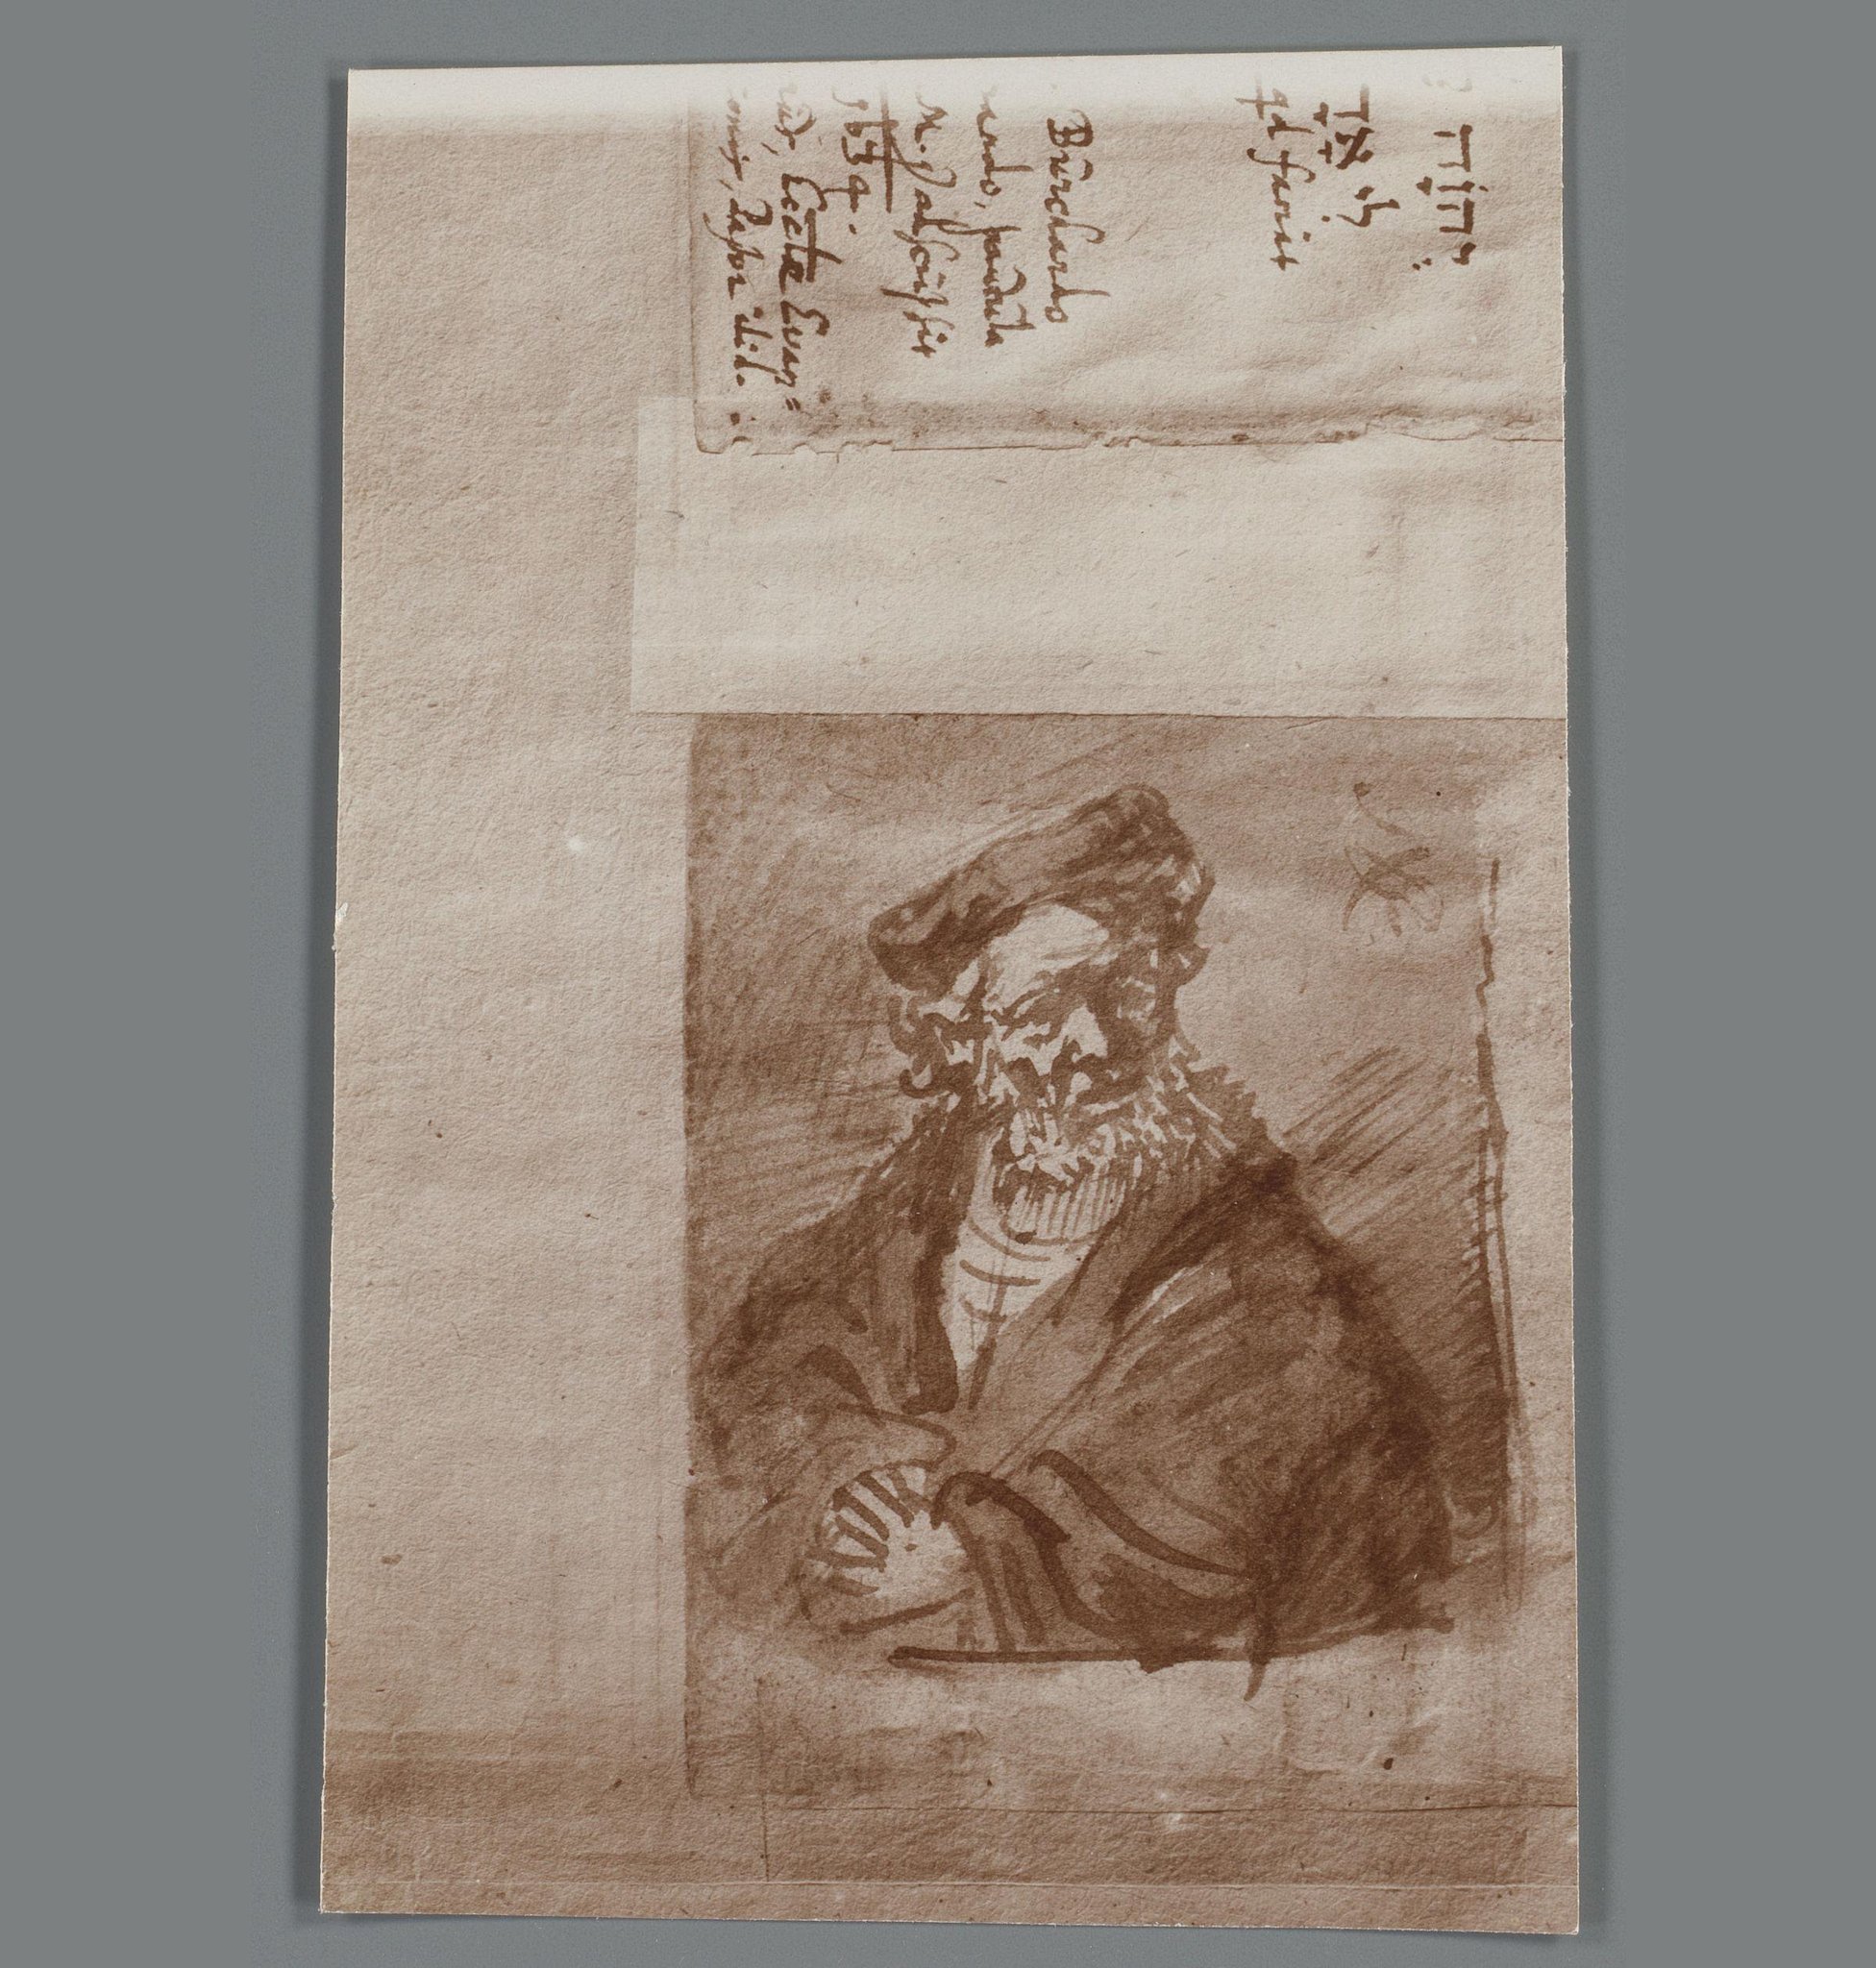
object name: photograph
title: Fotoreproductie van tekening van een oude man door Rembrandt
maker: Anonymous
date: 1880-1920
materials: paper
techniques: collodion silver print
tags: old man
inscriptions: inscription: ‘627 Rembrandt./ tekening uit/ het album van/ Burchard Grossmann/ Kon. Bibl.’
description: De oorspronkelijke tekening bevindt zich in het album amicorum van Burchard Grossmann.